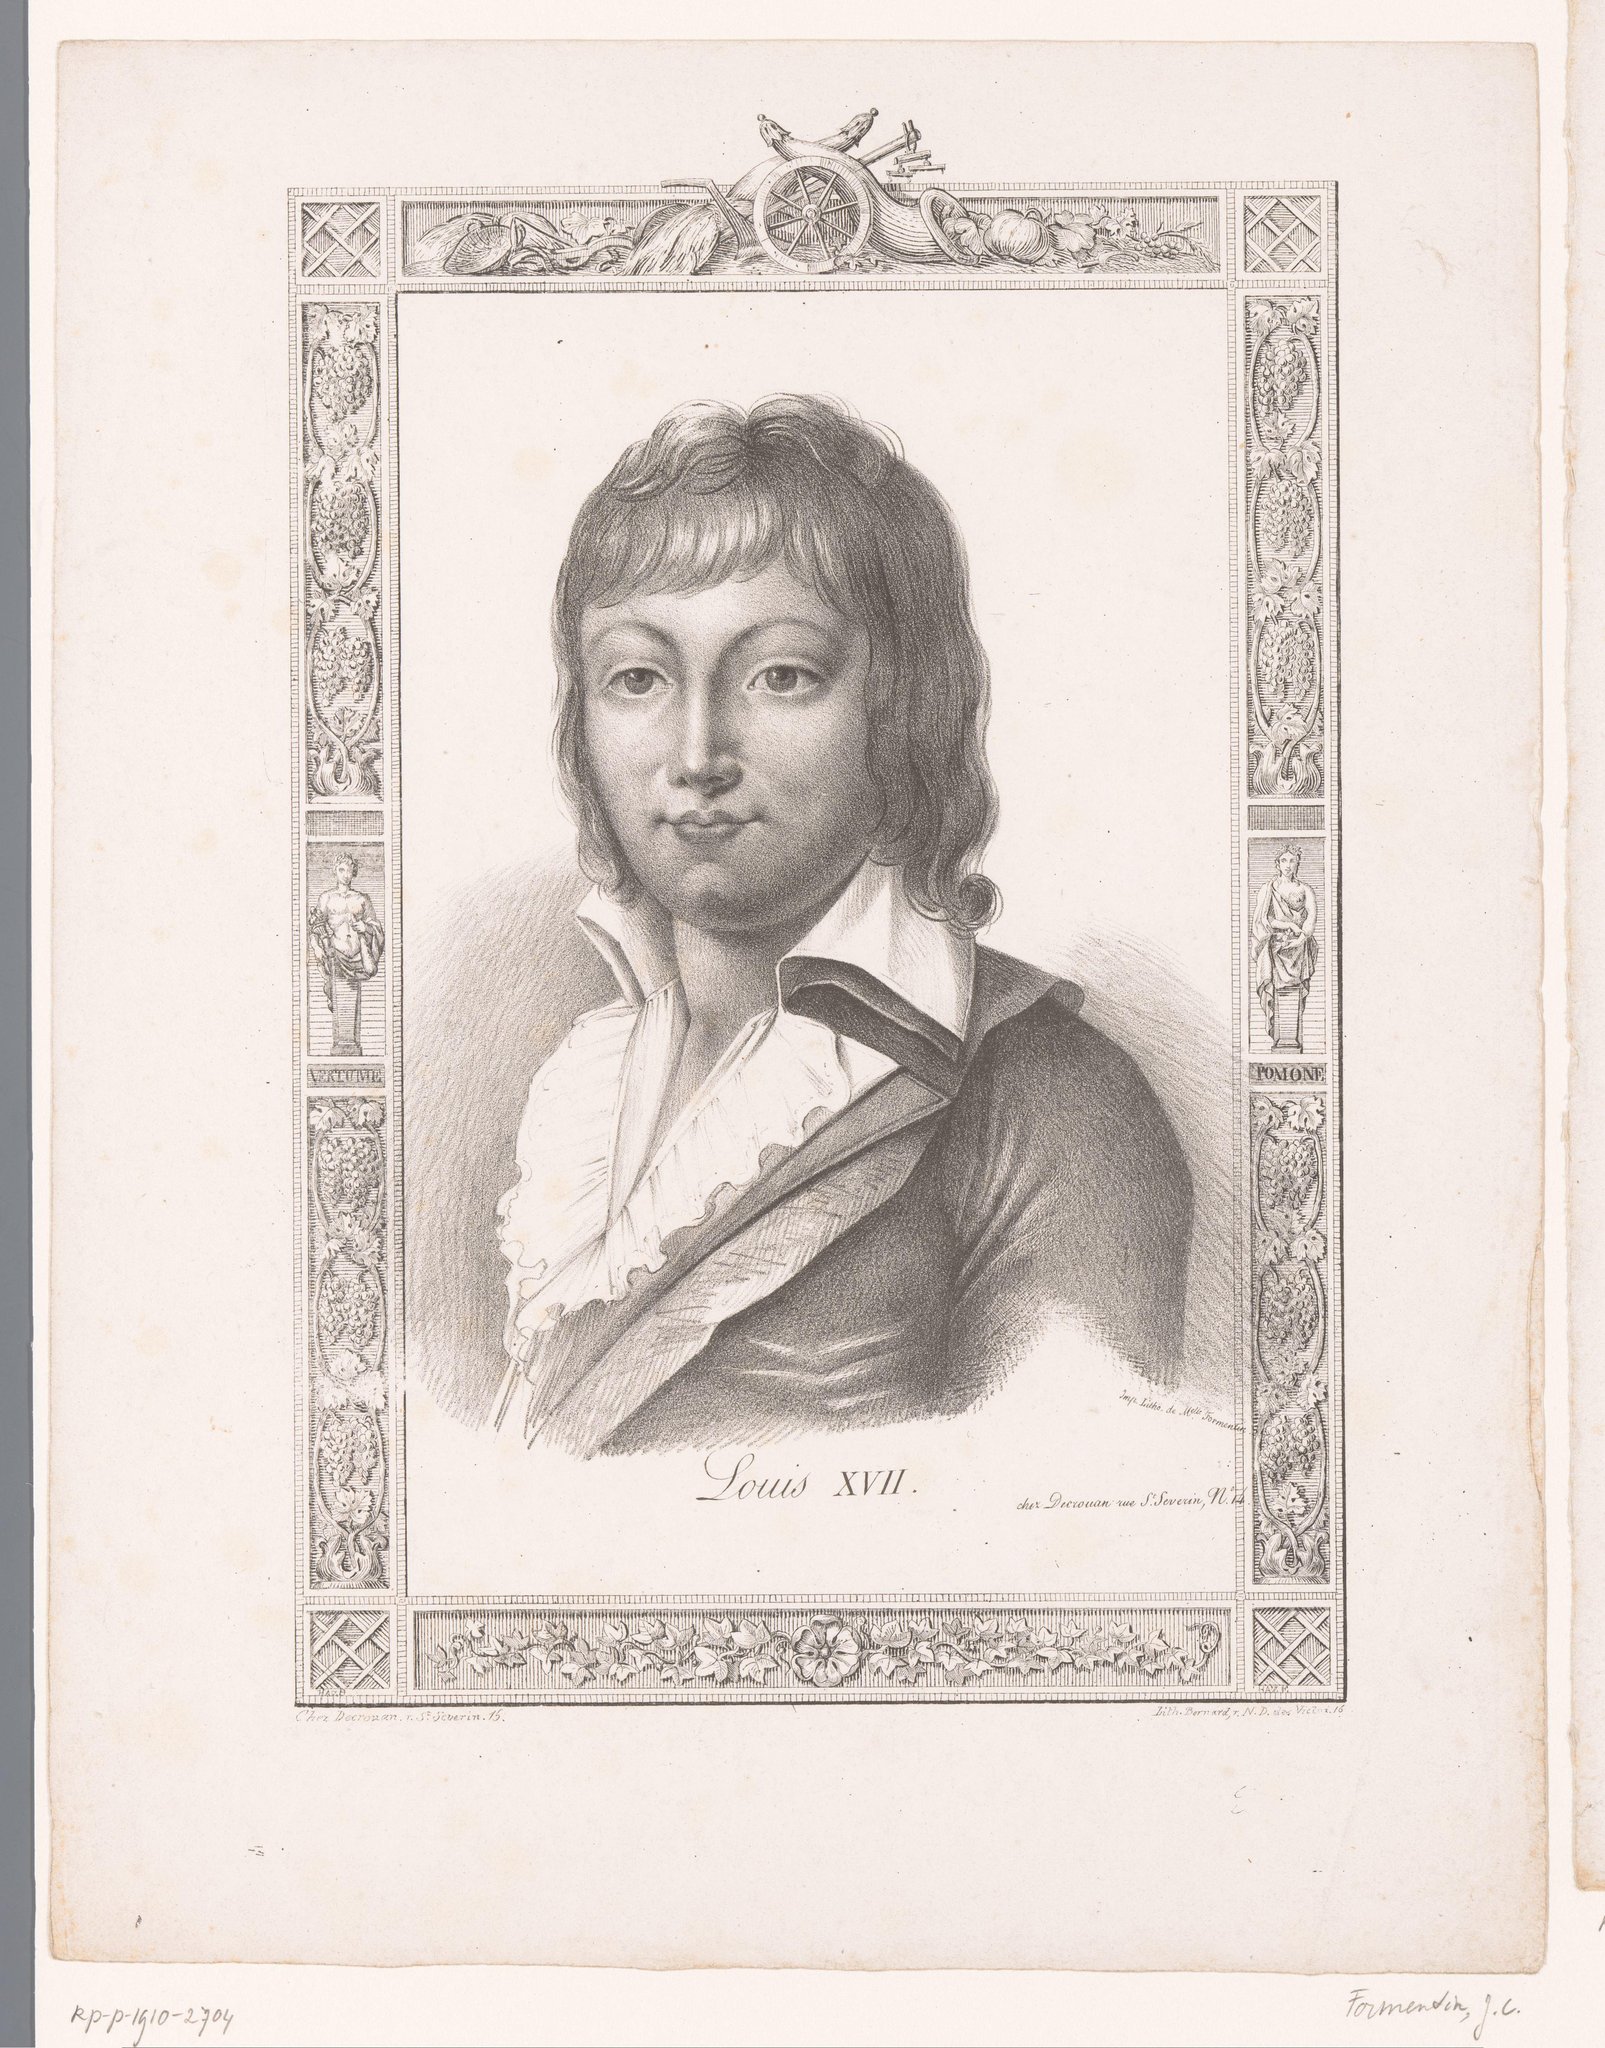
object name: print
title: Louis XVII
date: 1826-1829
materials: paper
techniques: lithograph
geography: paris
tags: historical persons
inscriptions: collector's mark: Lugt 2228a